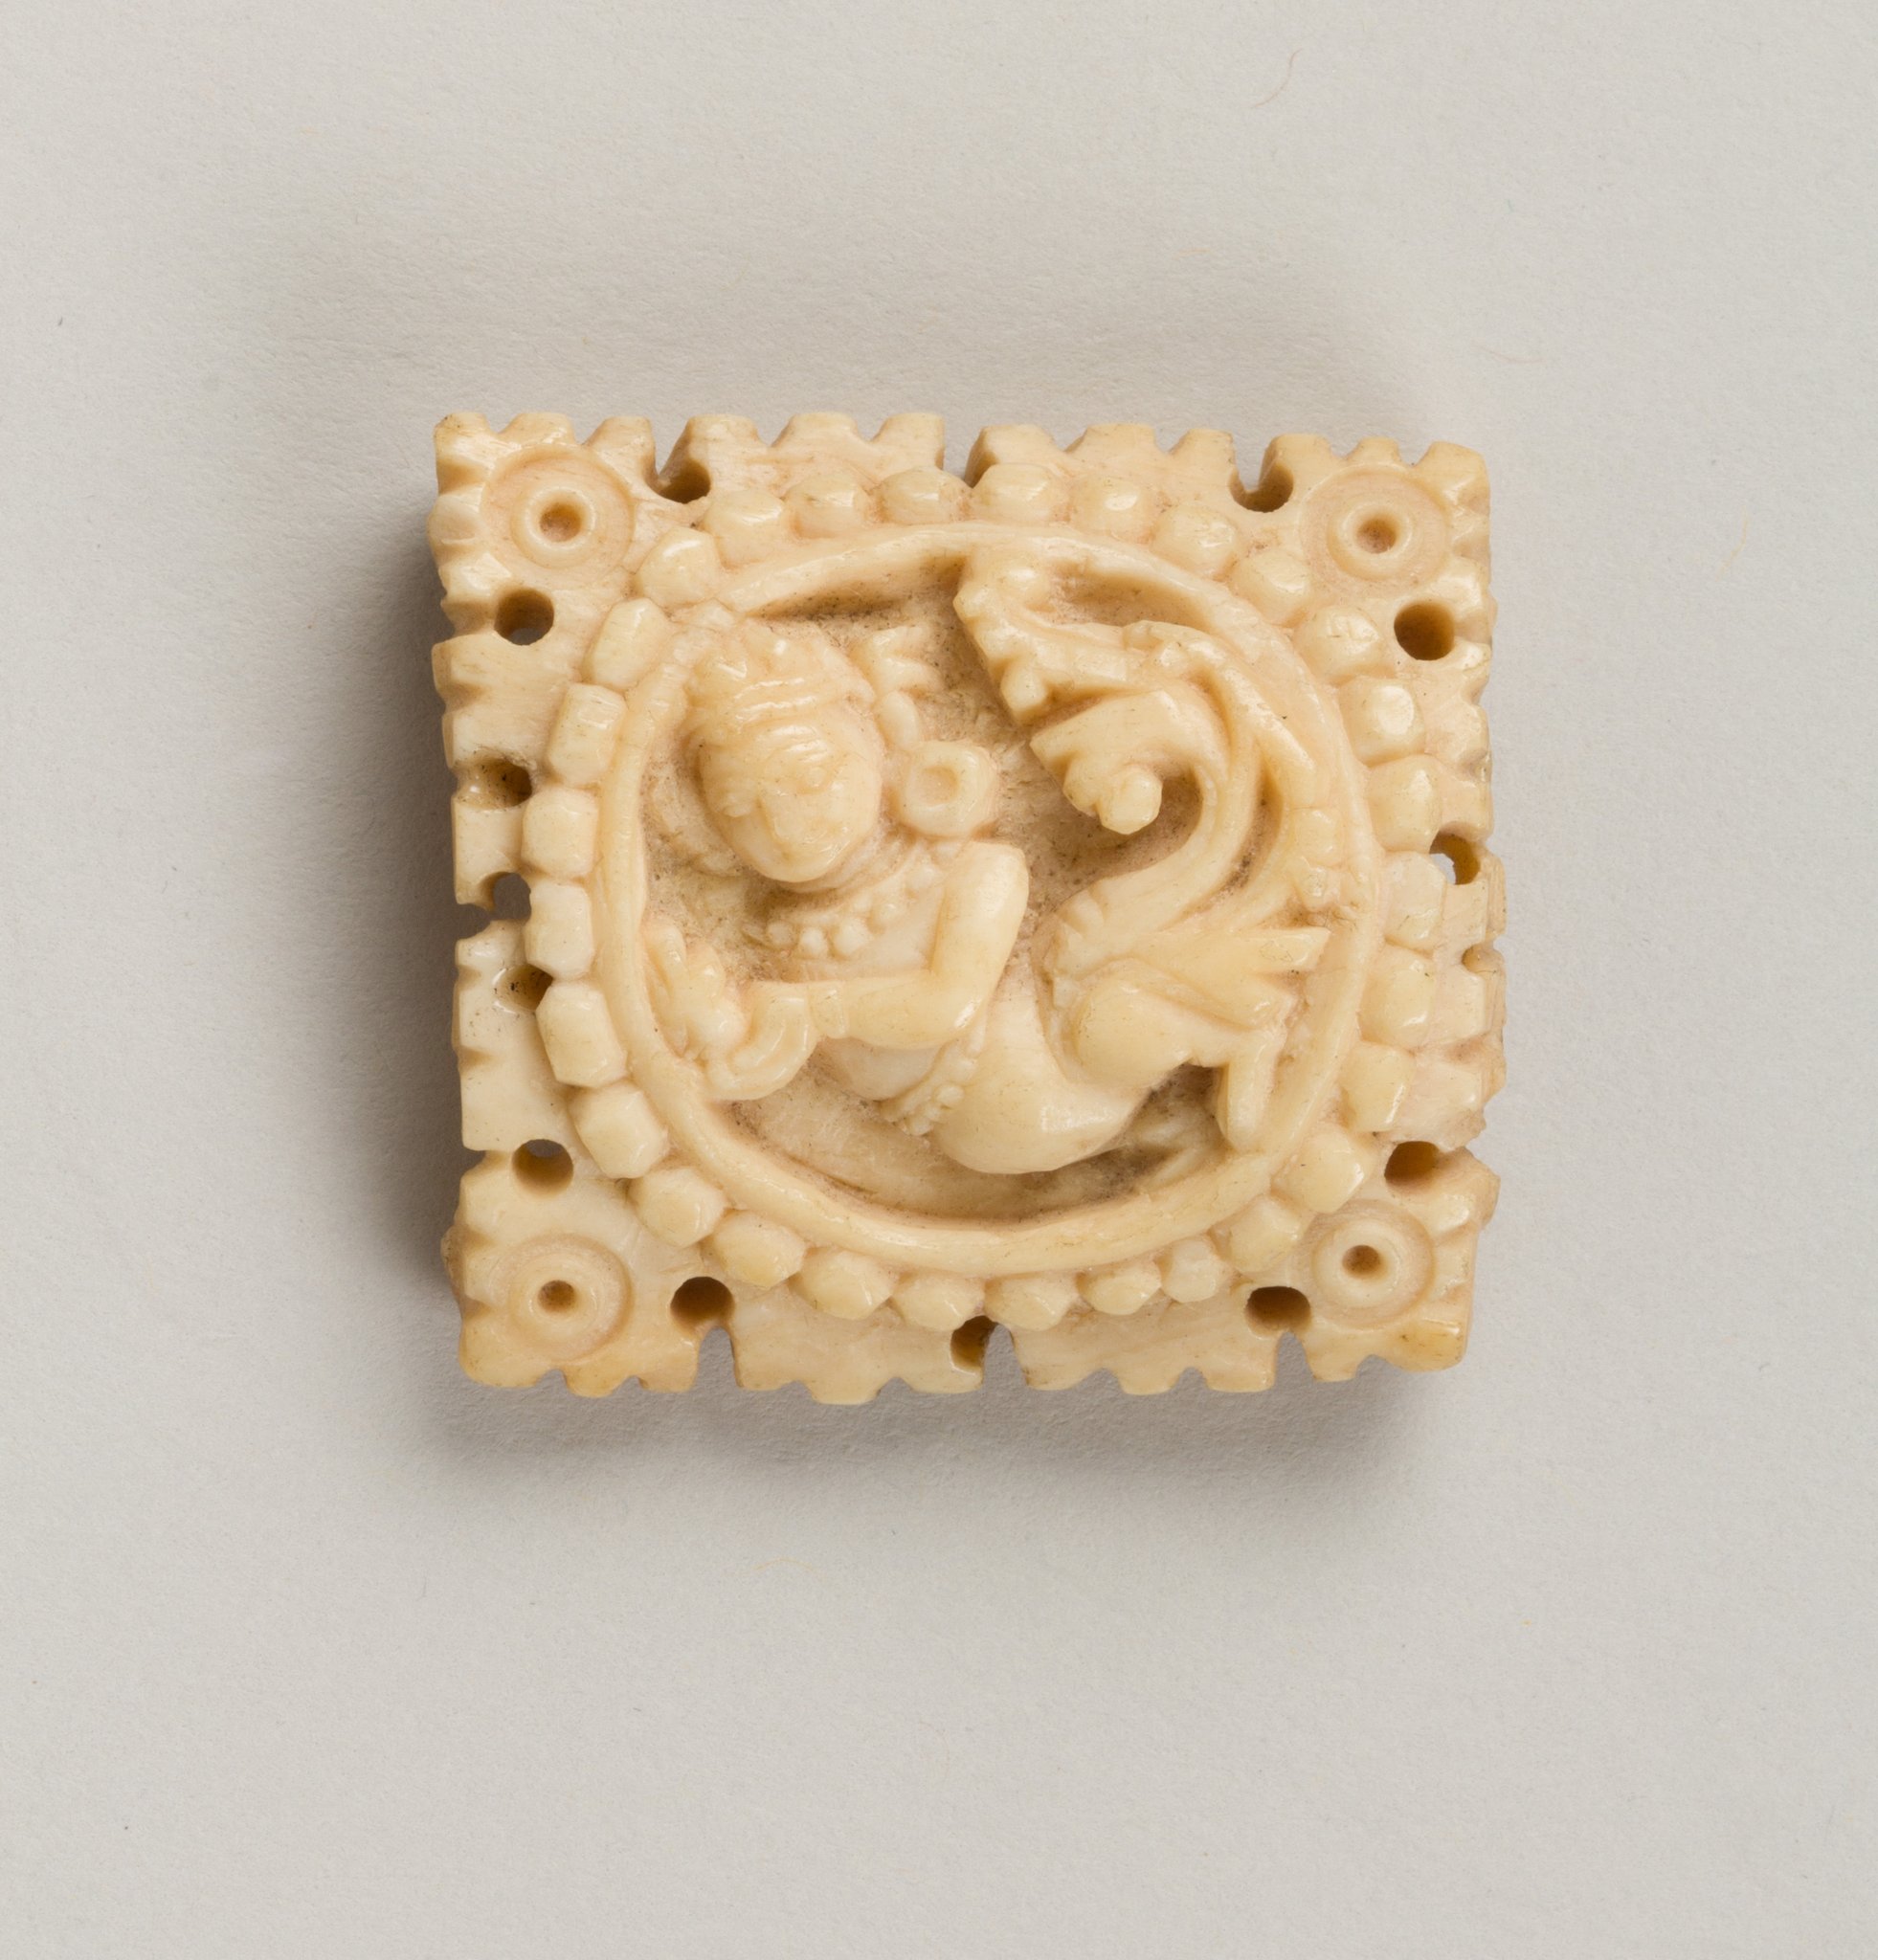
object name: plaque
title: Two Plaques from a Tantric Ritual Apron, Kinnari, and Lotus Flower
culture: tibetan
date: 1501-1600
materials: bone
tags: hinduism